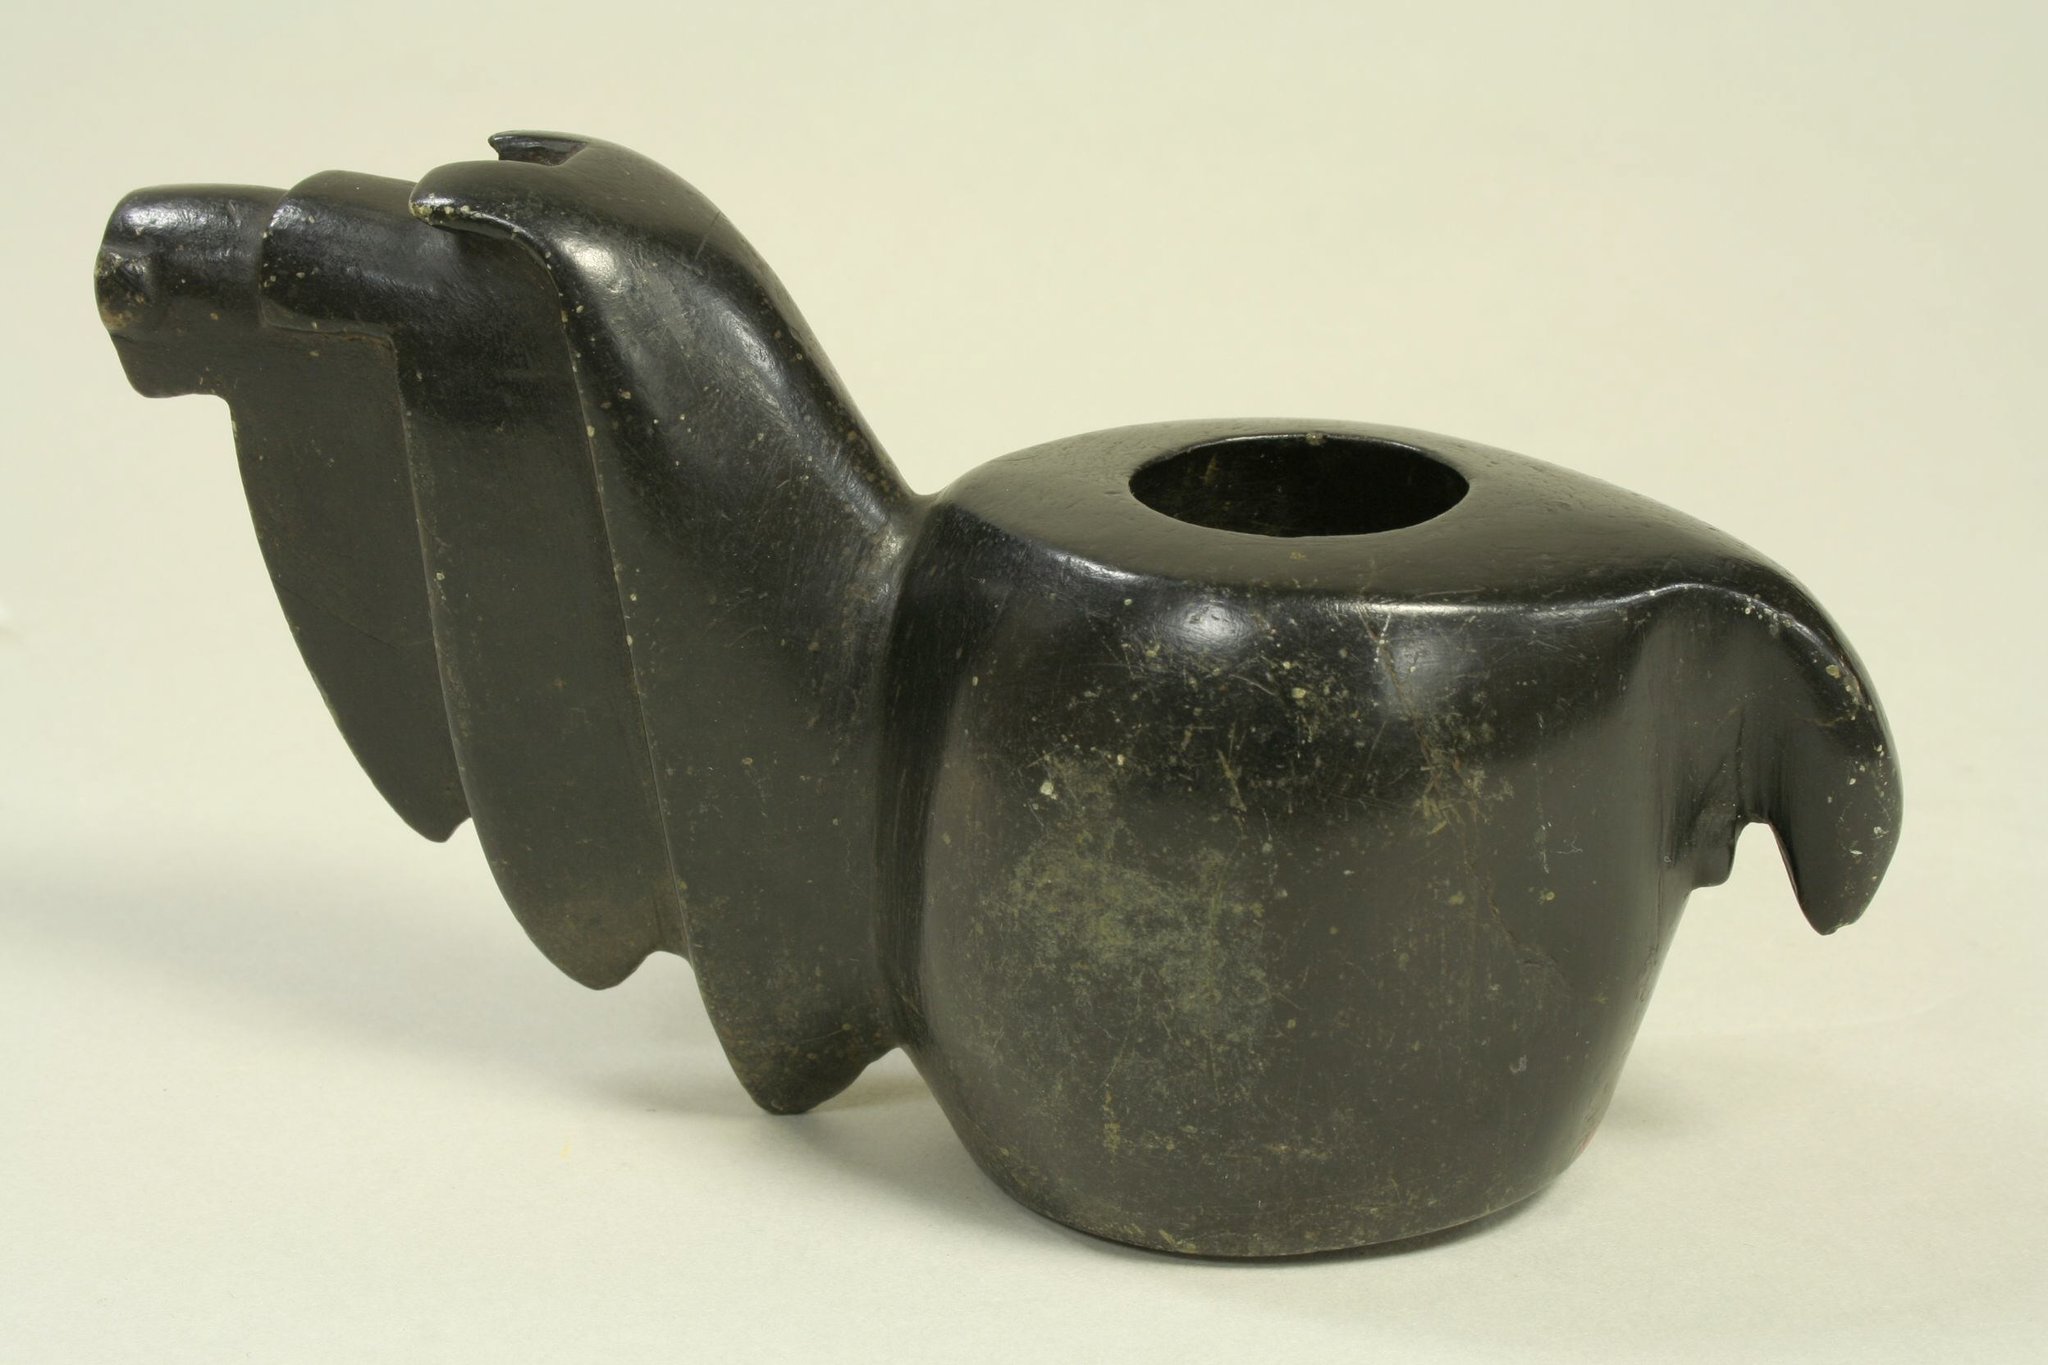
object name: container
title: Votive Container (Canopa)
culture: inca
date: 1401-1500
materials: stone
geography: peru